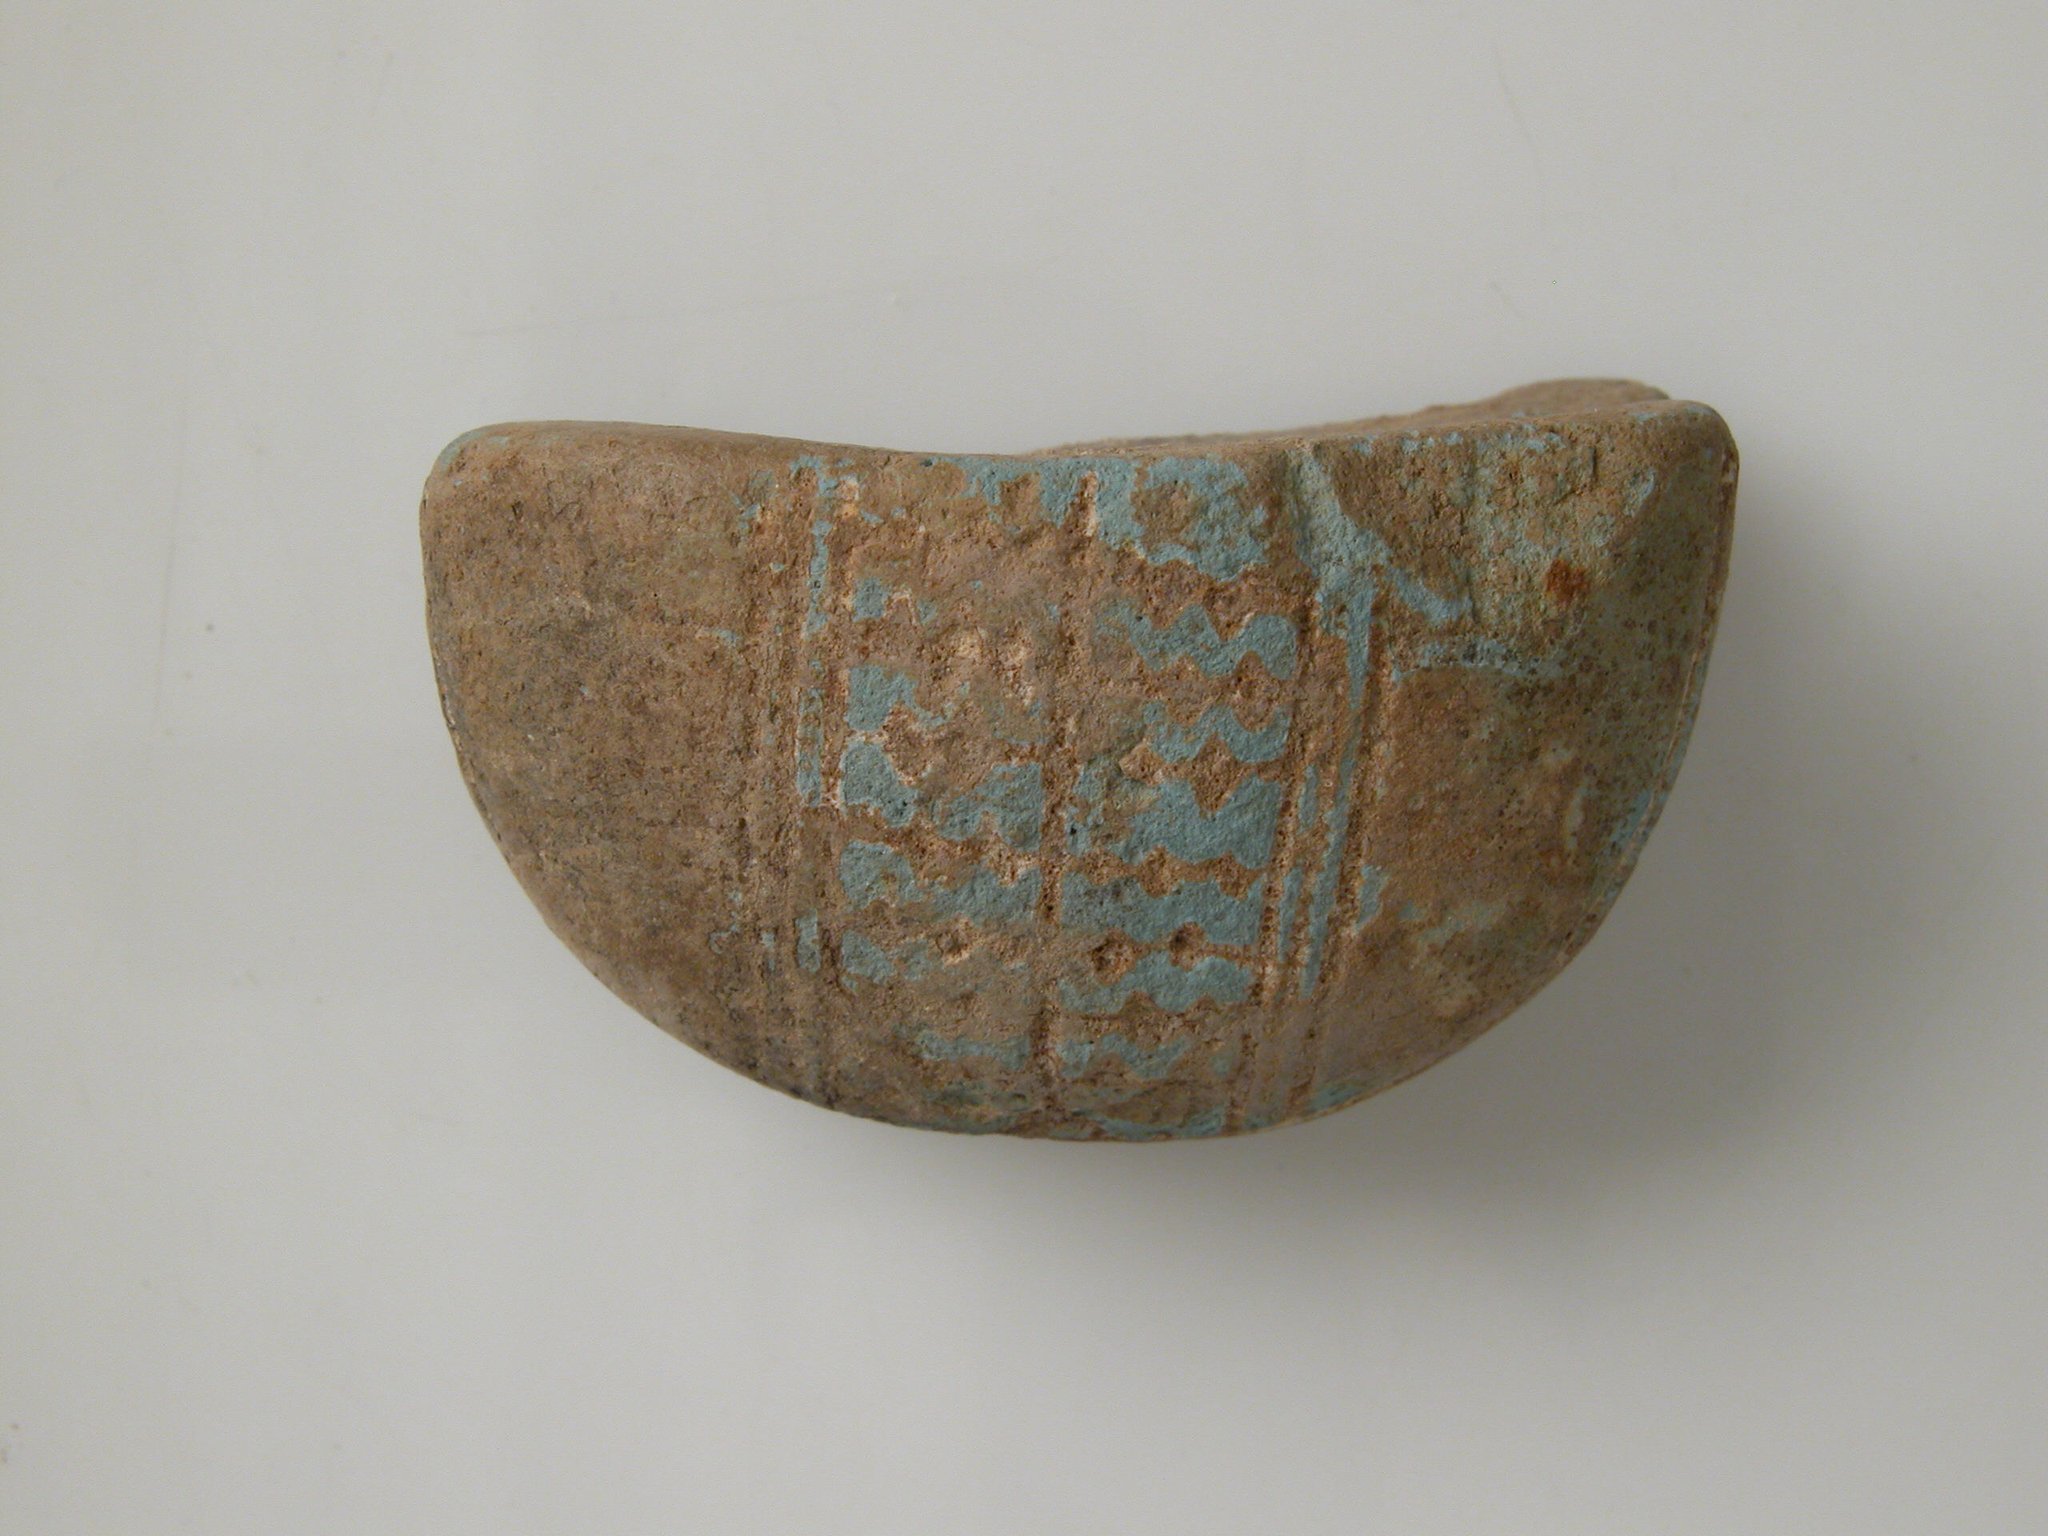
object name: necklace, bead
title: Amulet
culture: coptic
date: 301-700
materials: faience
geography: egypt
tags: amulets